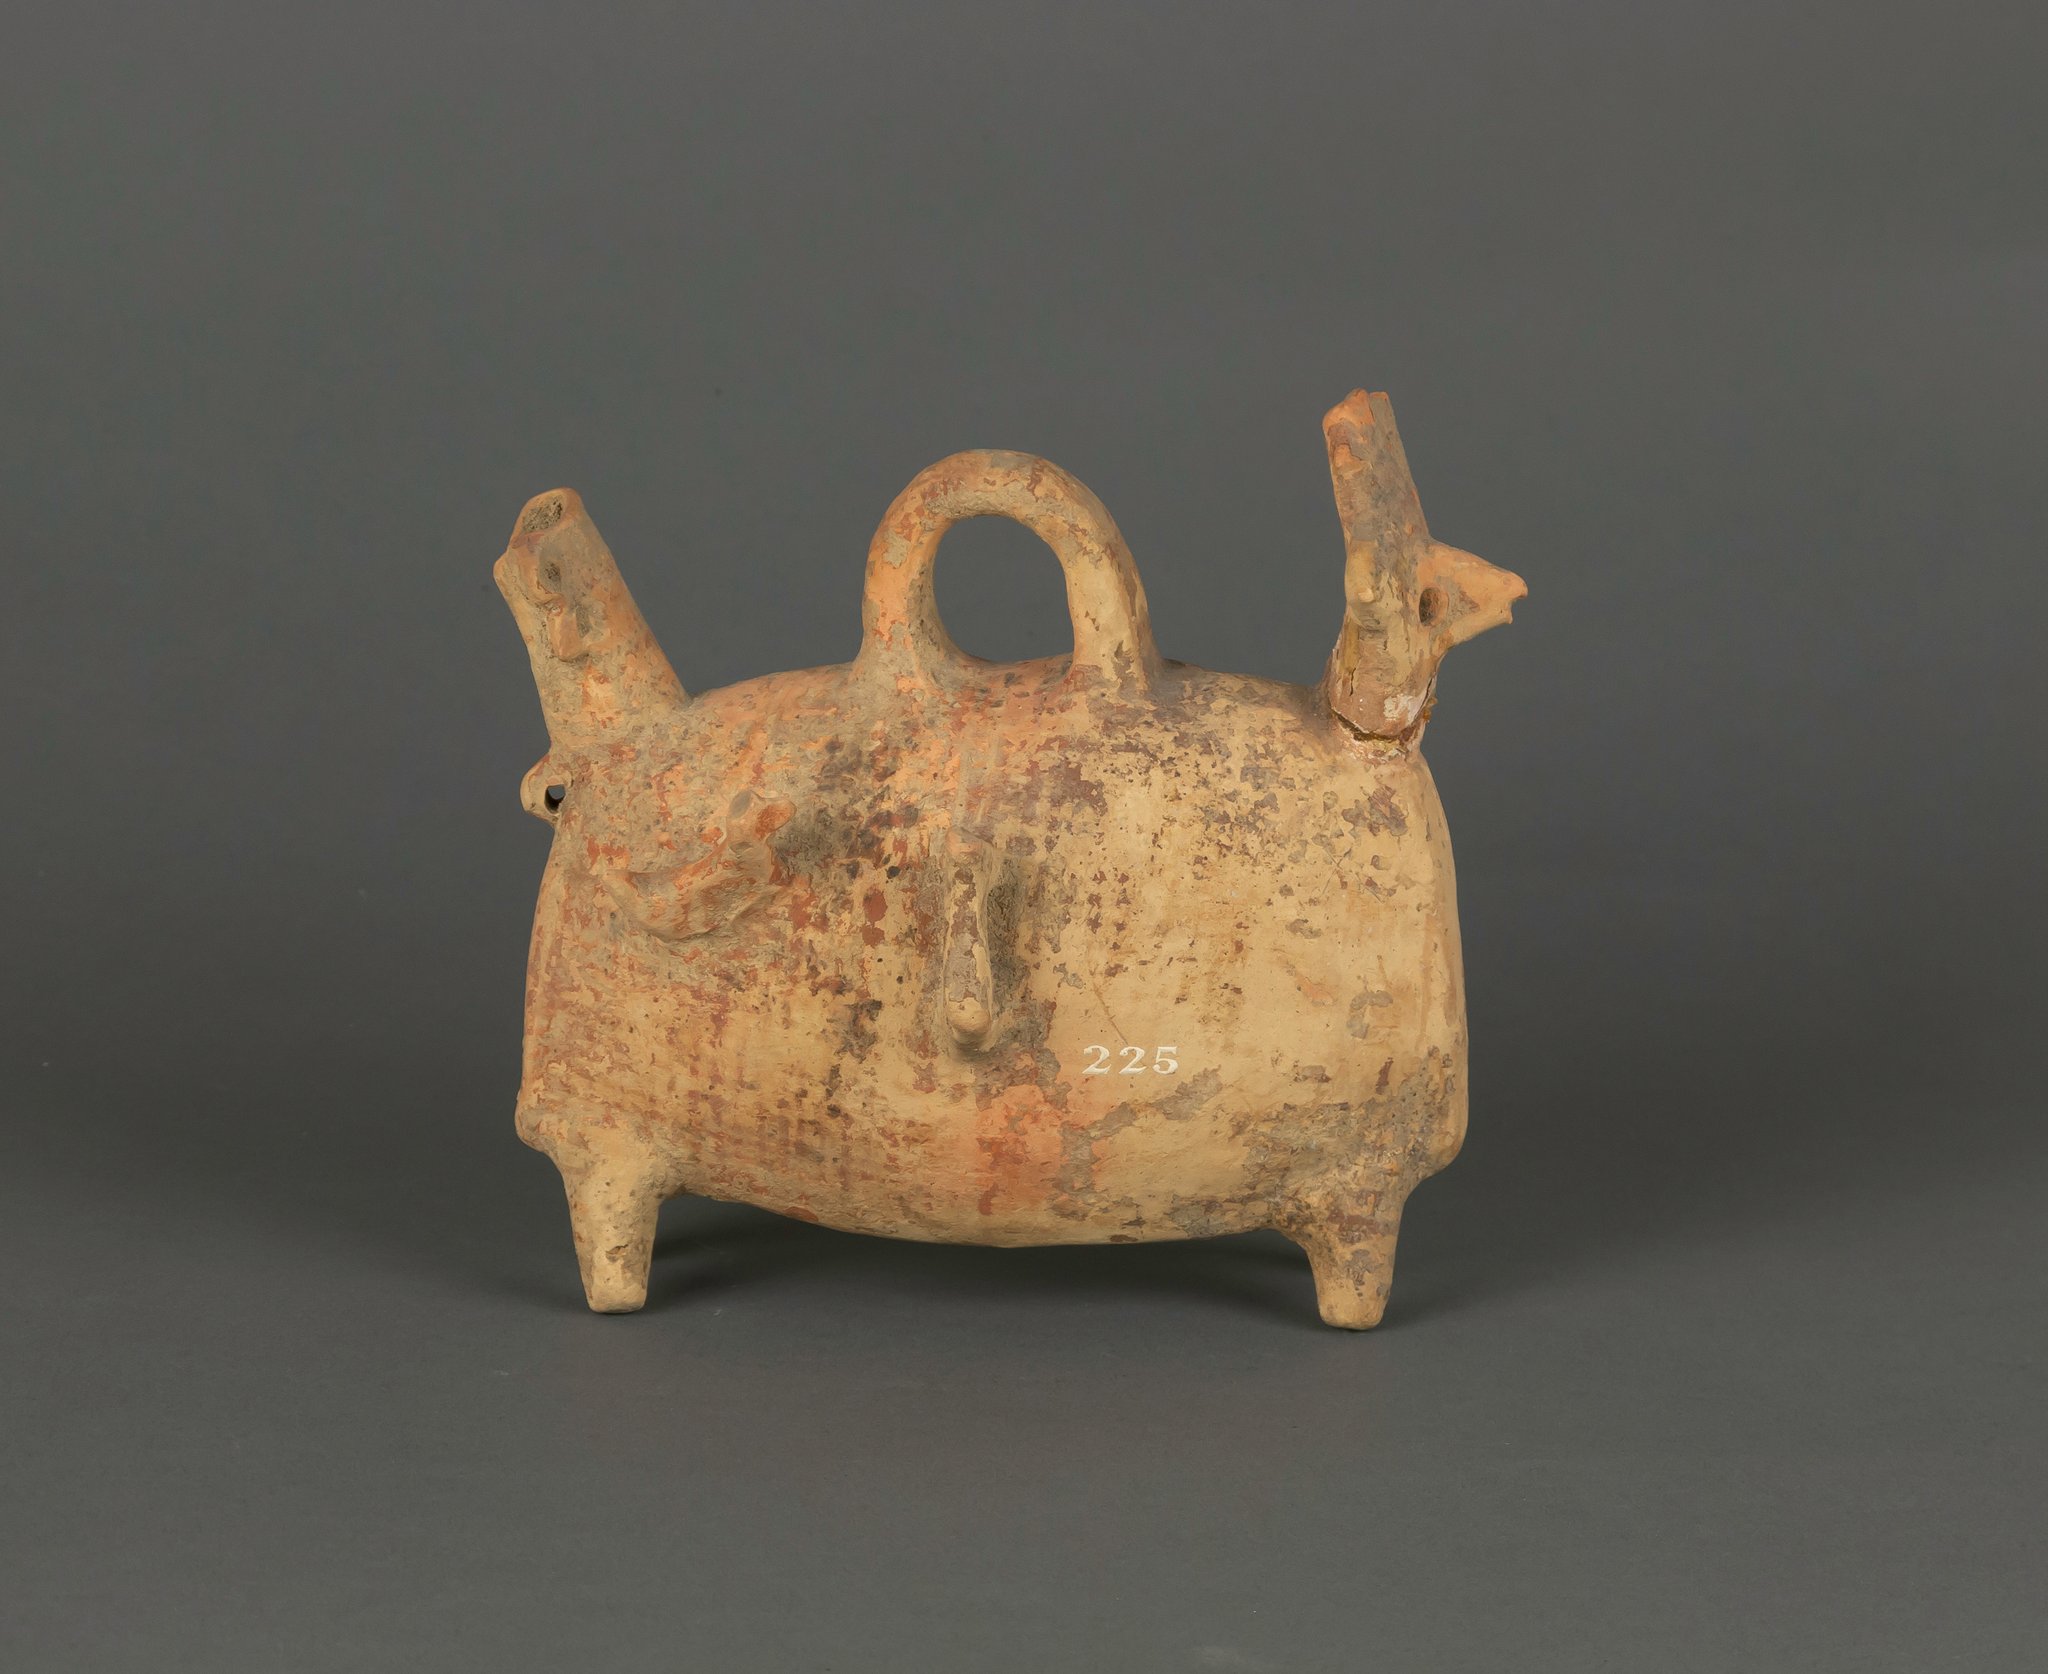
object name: askos in the form of an animal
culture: cypriot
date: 1900-1600 BCE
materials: terracotta